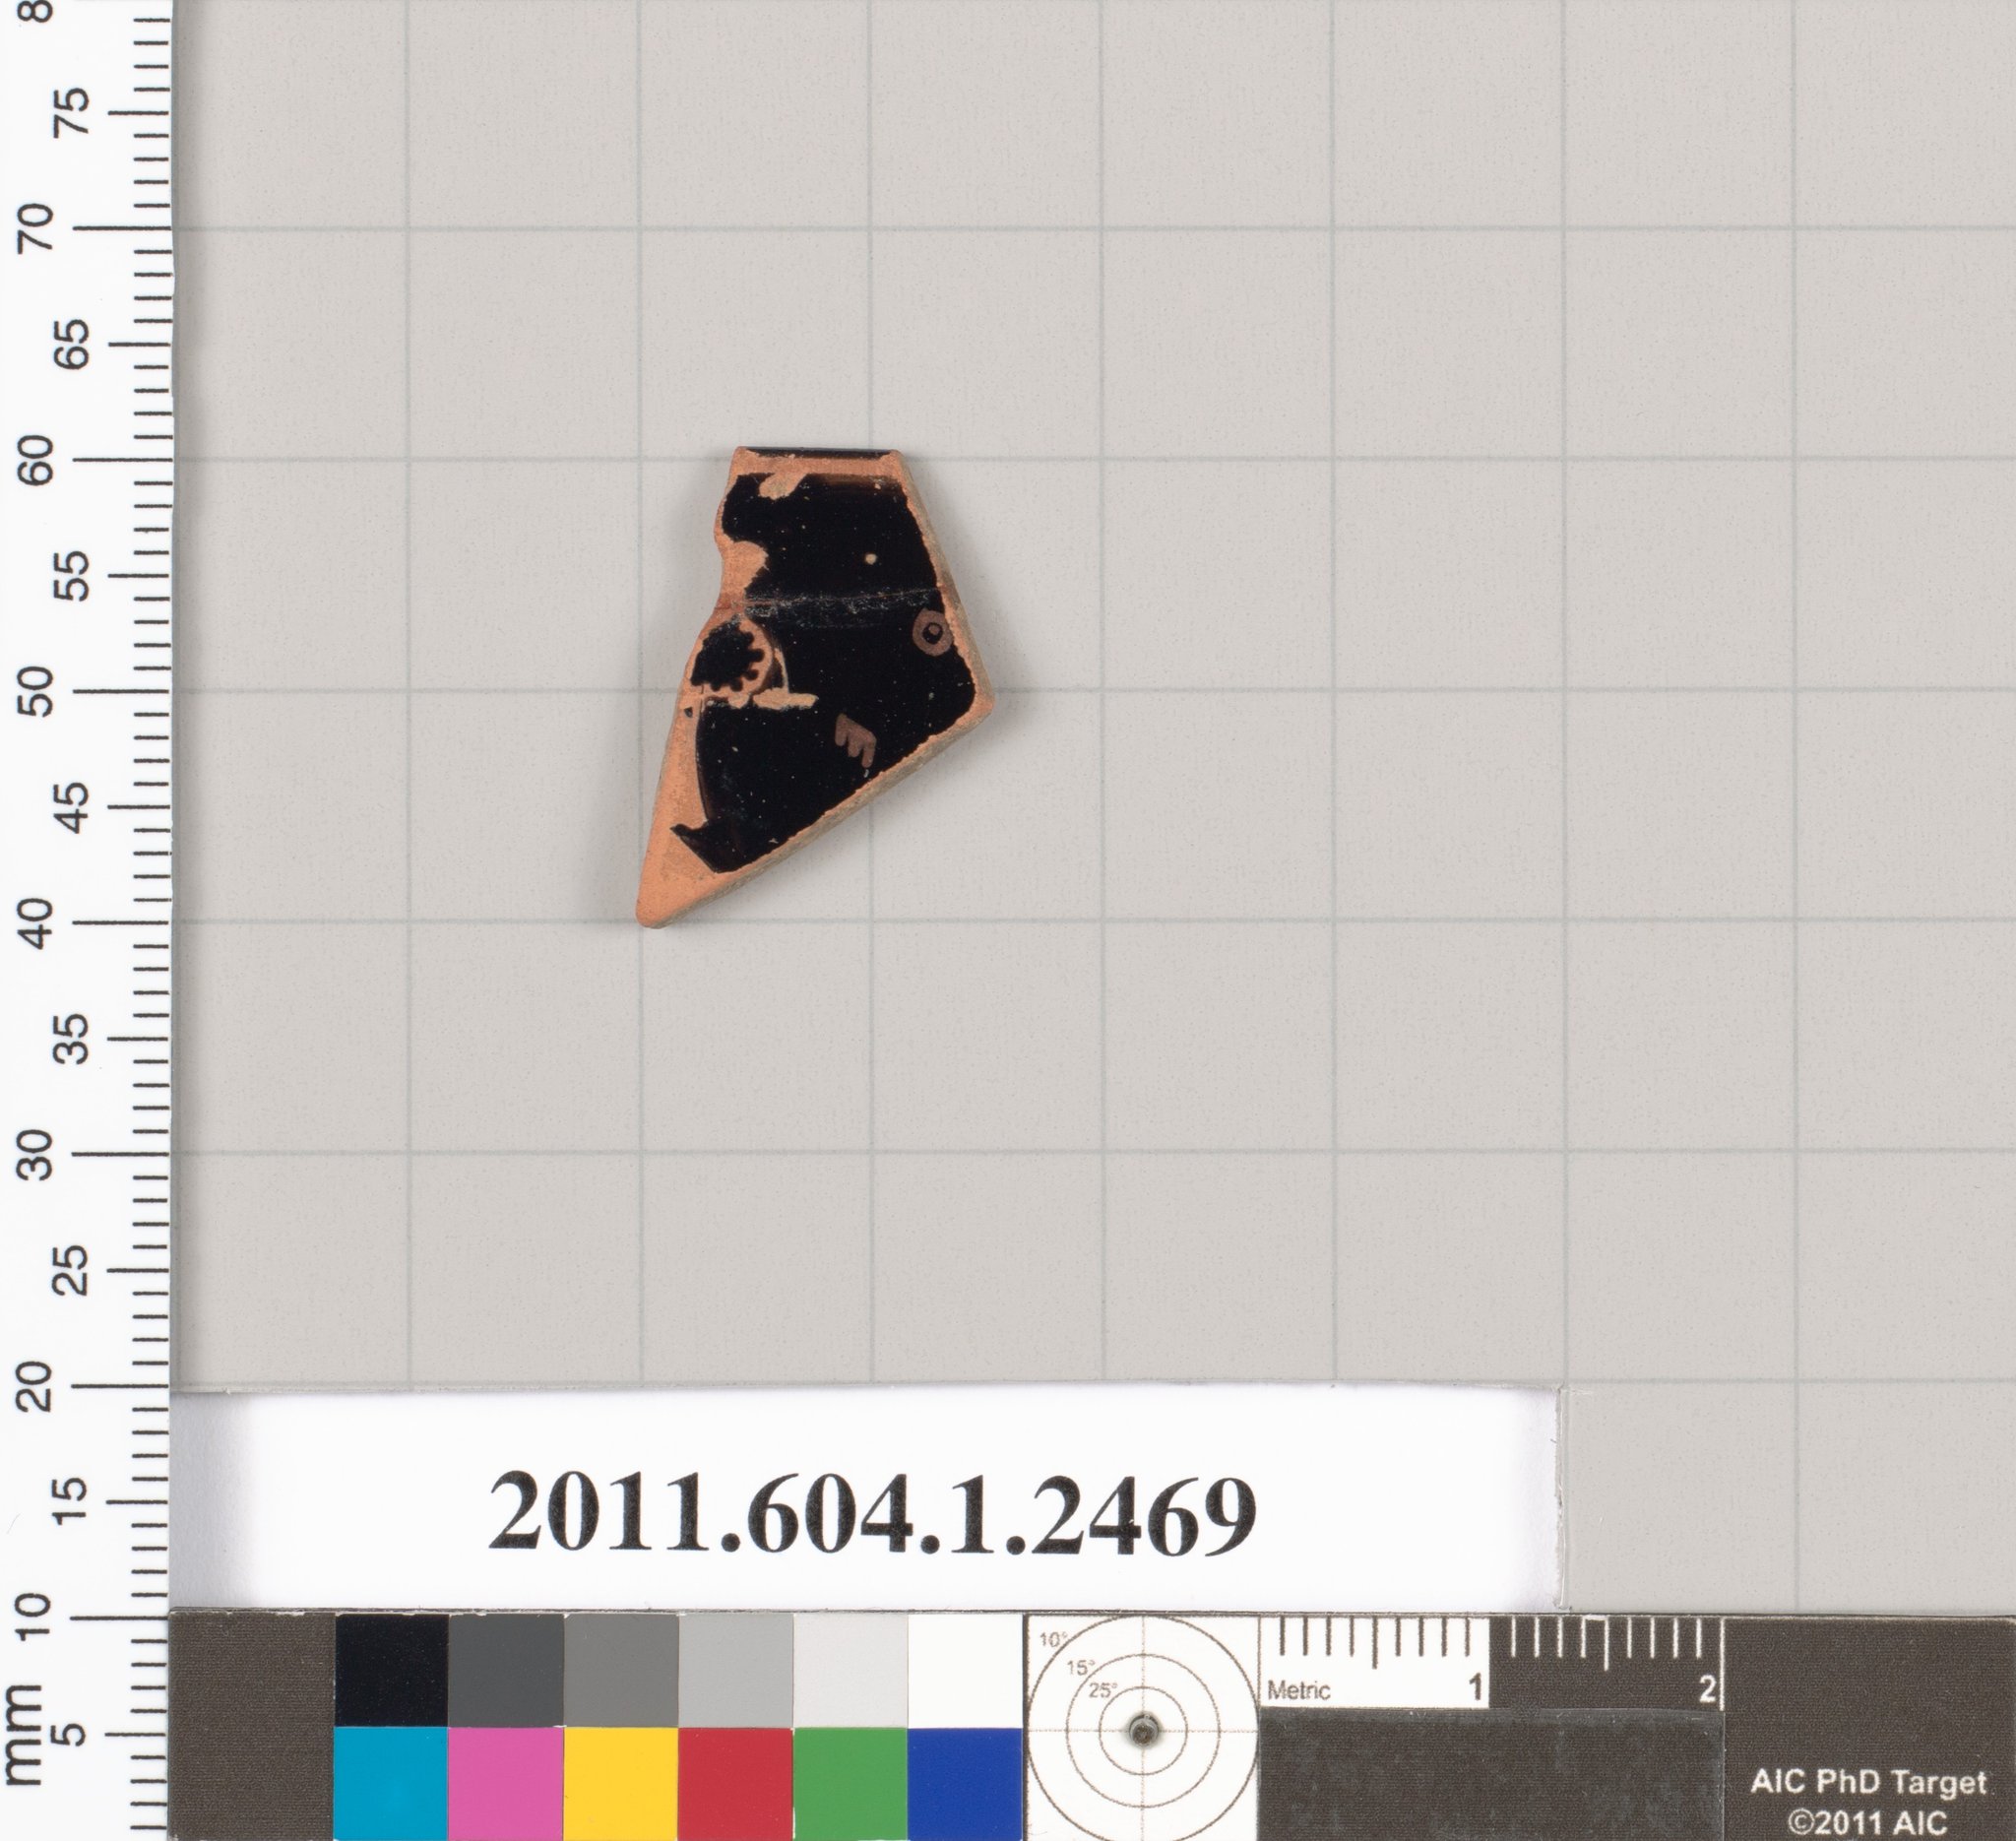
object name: kylix fragment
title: Terracotta rim fragment of a kylix (drinking cup)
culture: greek, attic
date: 500-480 BCE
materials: terracotta